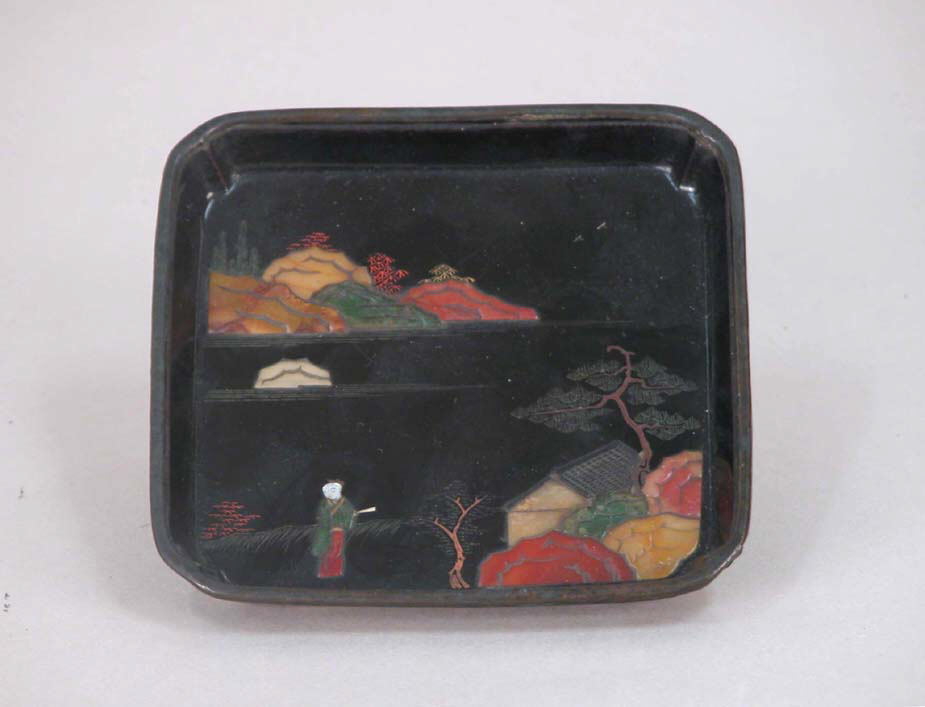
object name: tray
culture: chinese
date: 1601-1700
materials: lacquer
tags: hills,trees